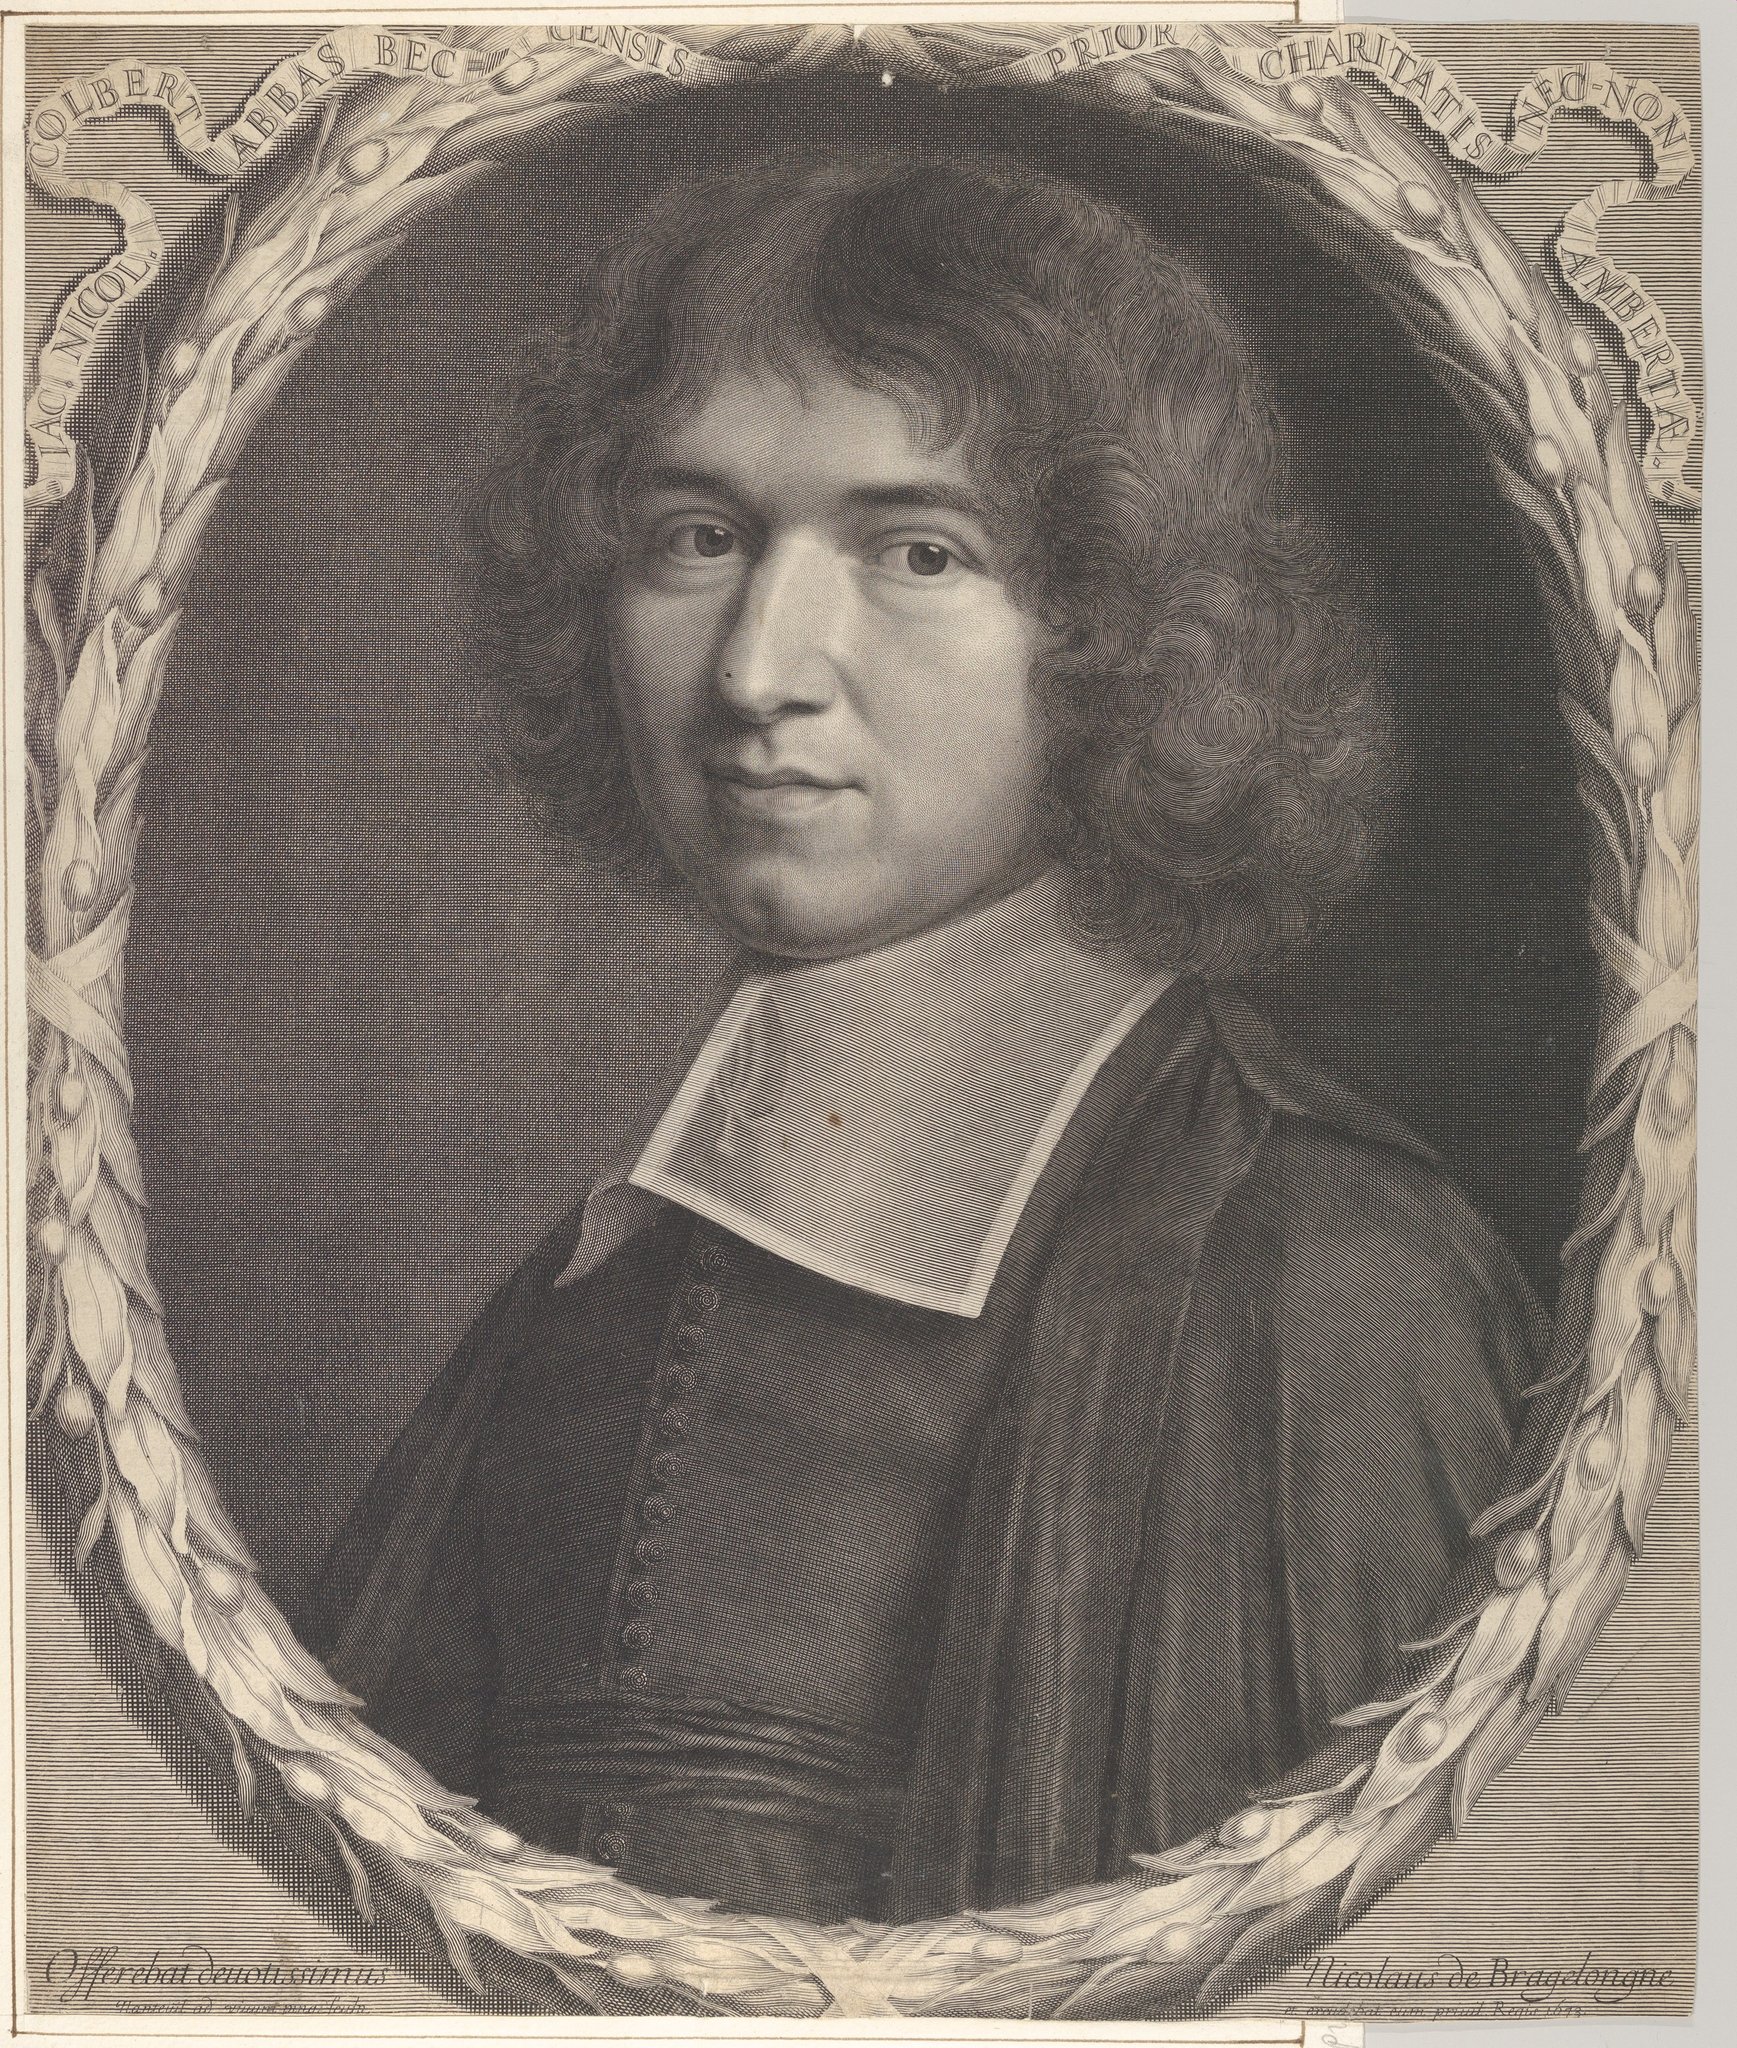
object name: print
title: Jacques-Nicolas Colbert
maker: robert nanteuil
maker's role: artist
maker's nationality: french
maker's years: 1623-1678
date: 1673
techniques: engraving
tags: men,portraits